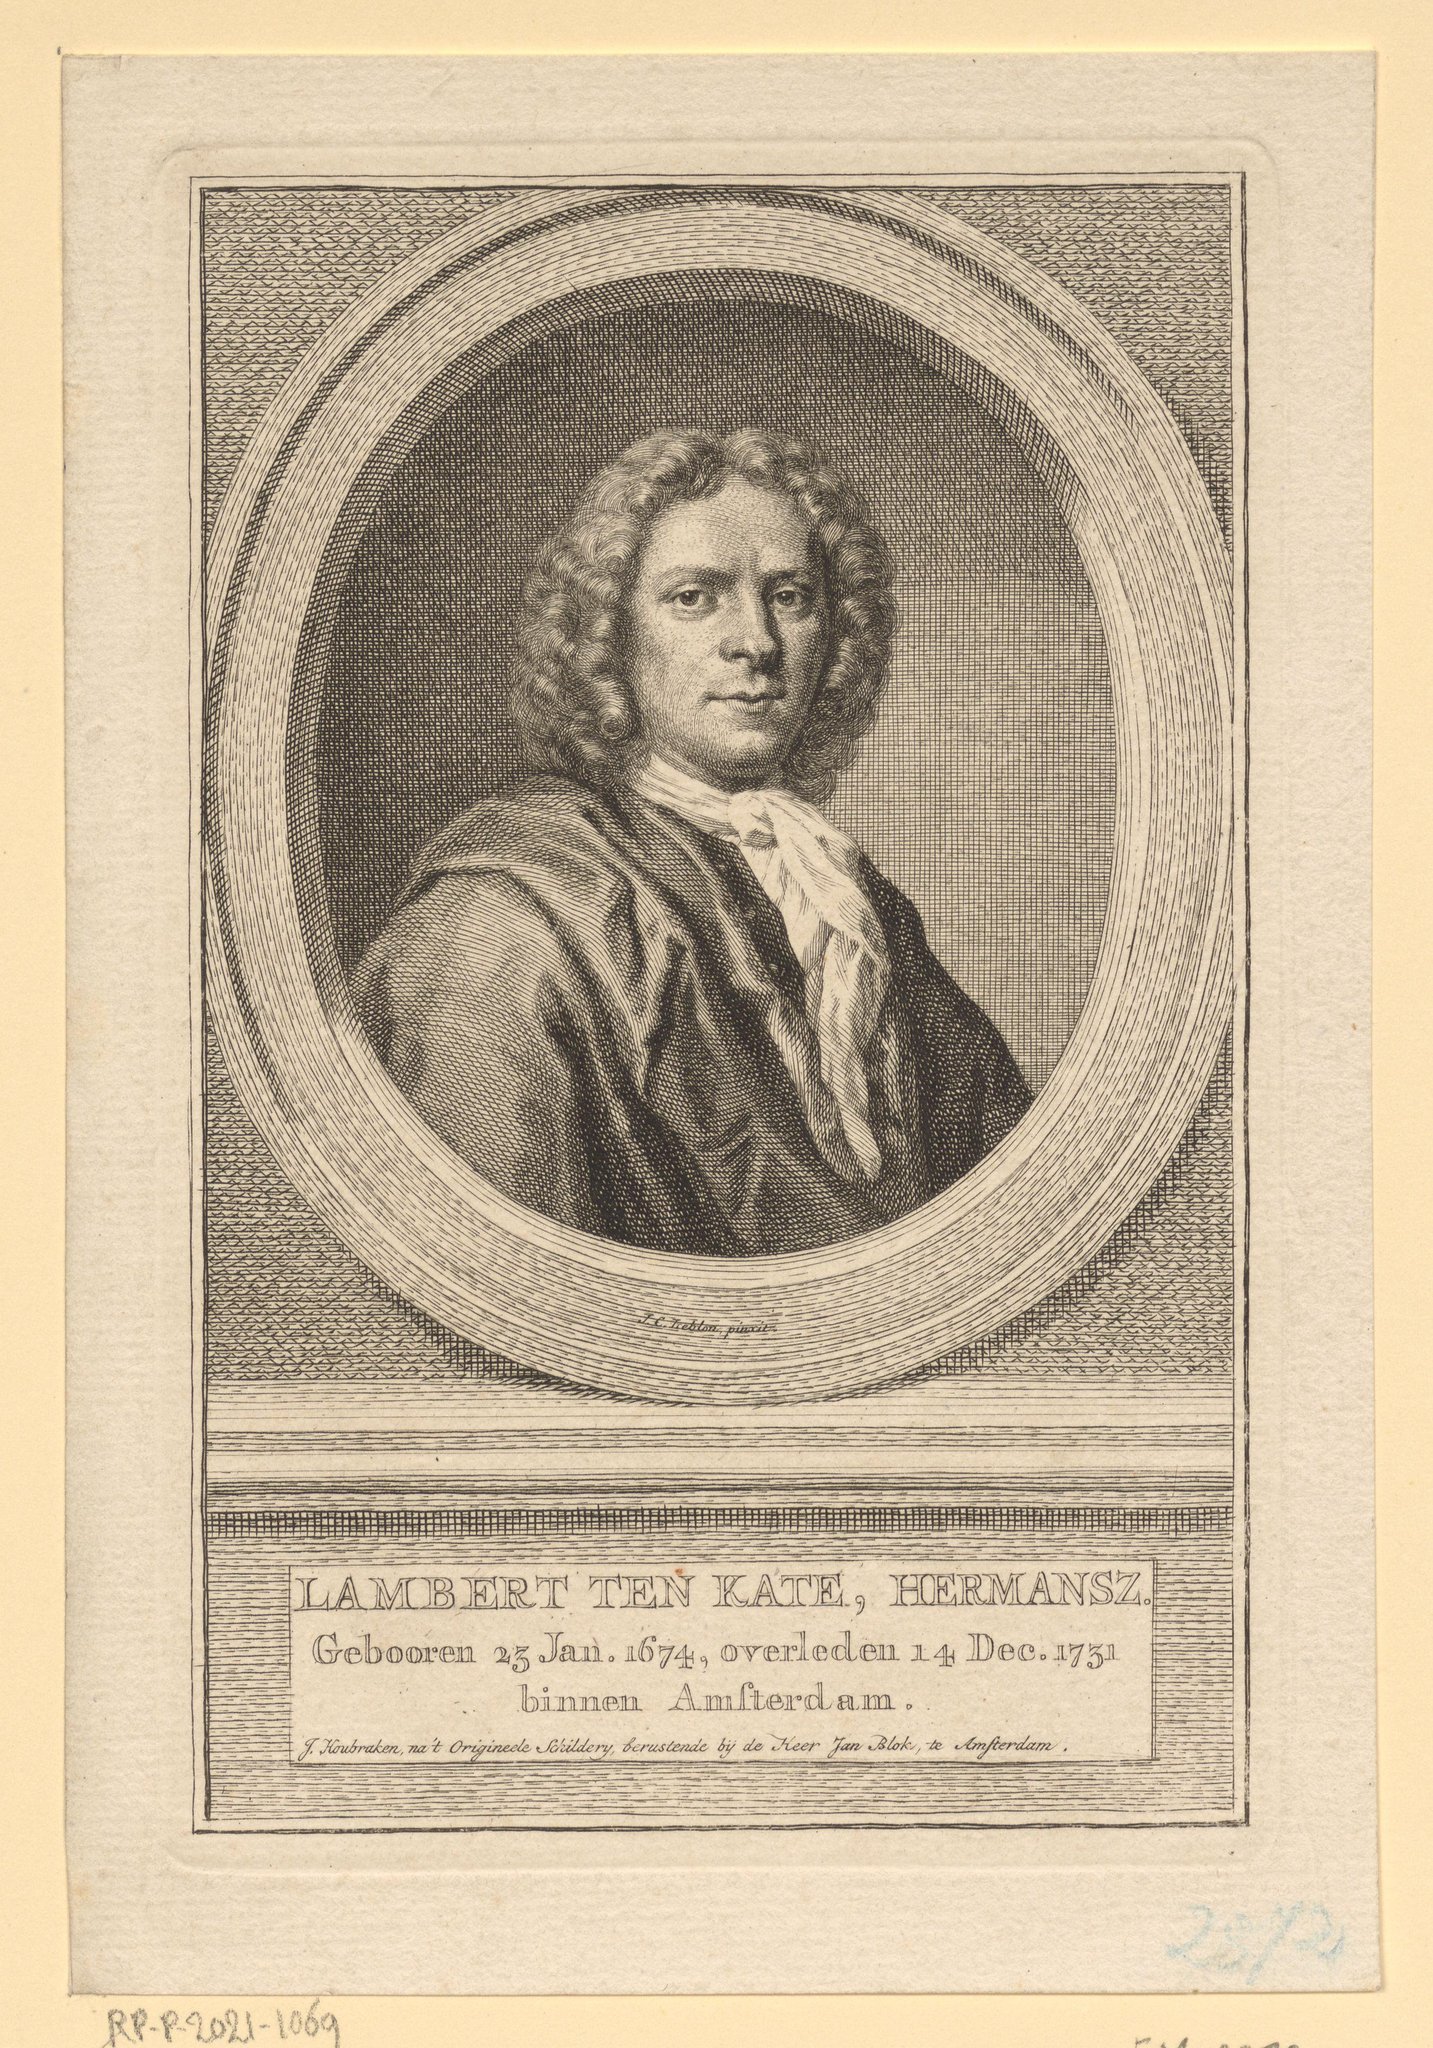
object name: print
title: Portret van Lambert ten Kate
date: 1731-1780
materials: paper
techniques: engraving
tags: print maker, lambert ten kate, scholar, philosopher, historical persons